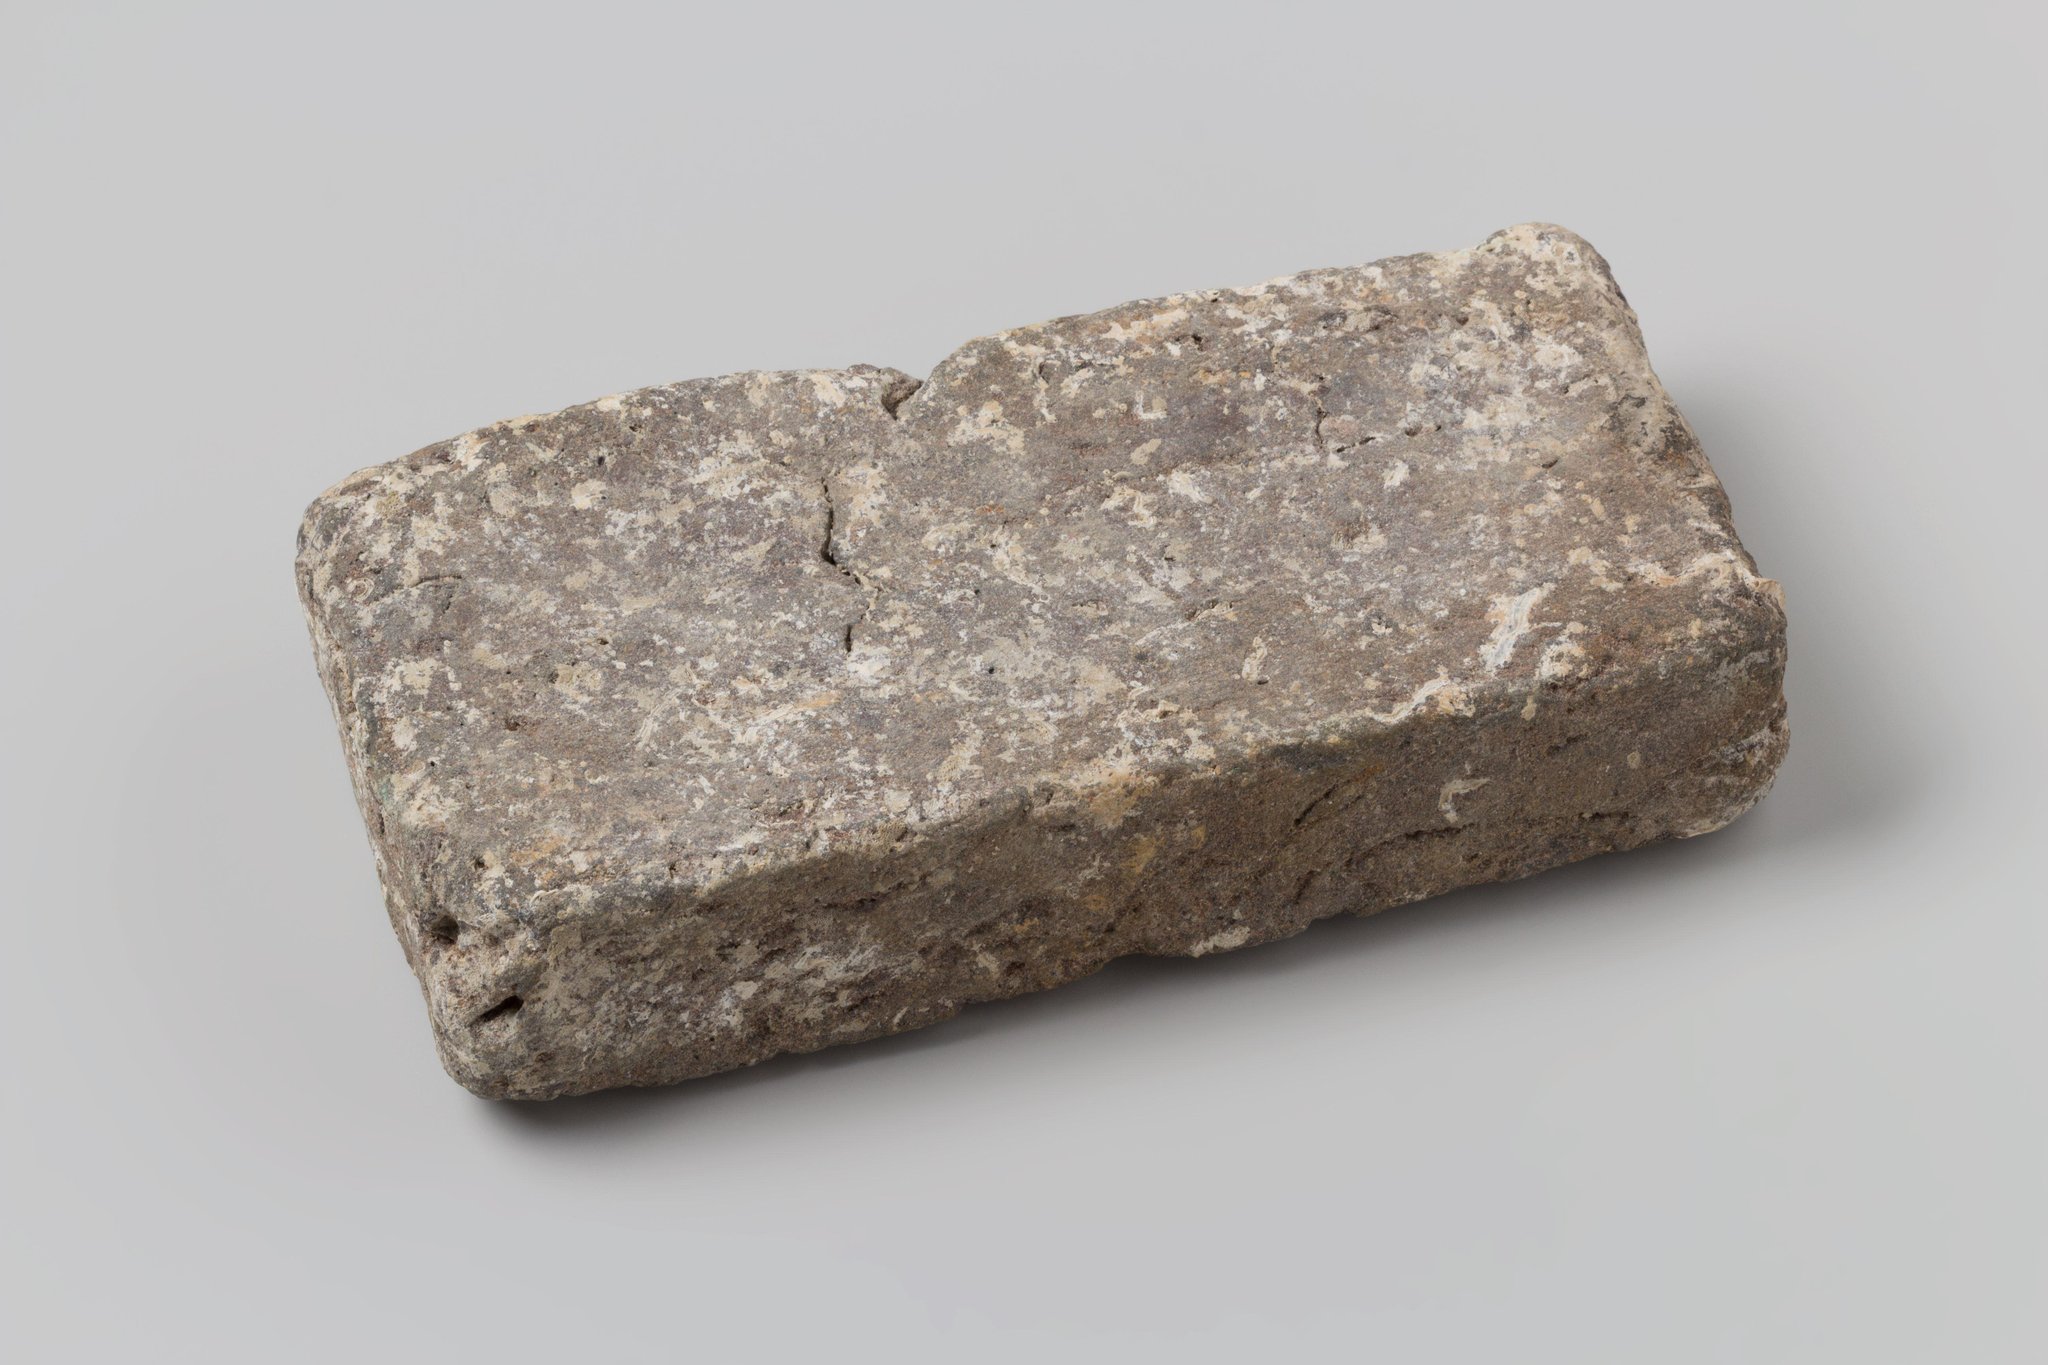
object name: brick clay product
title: Baksteen uit het wrak van de Oost-Indiëvaarder Hollandia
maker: Anonymous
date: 1700-1743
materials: brick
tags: verenigde oostindische compagnie, hollandia (schip)